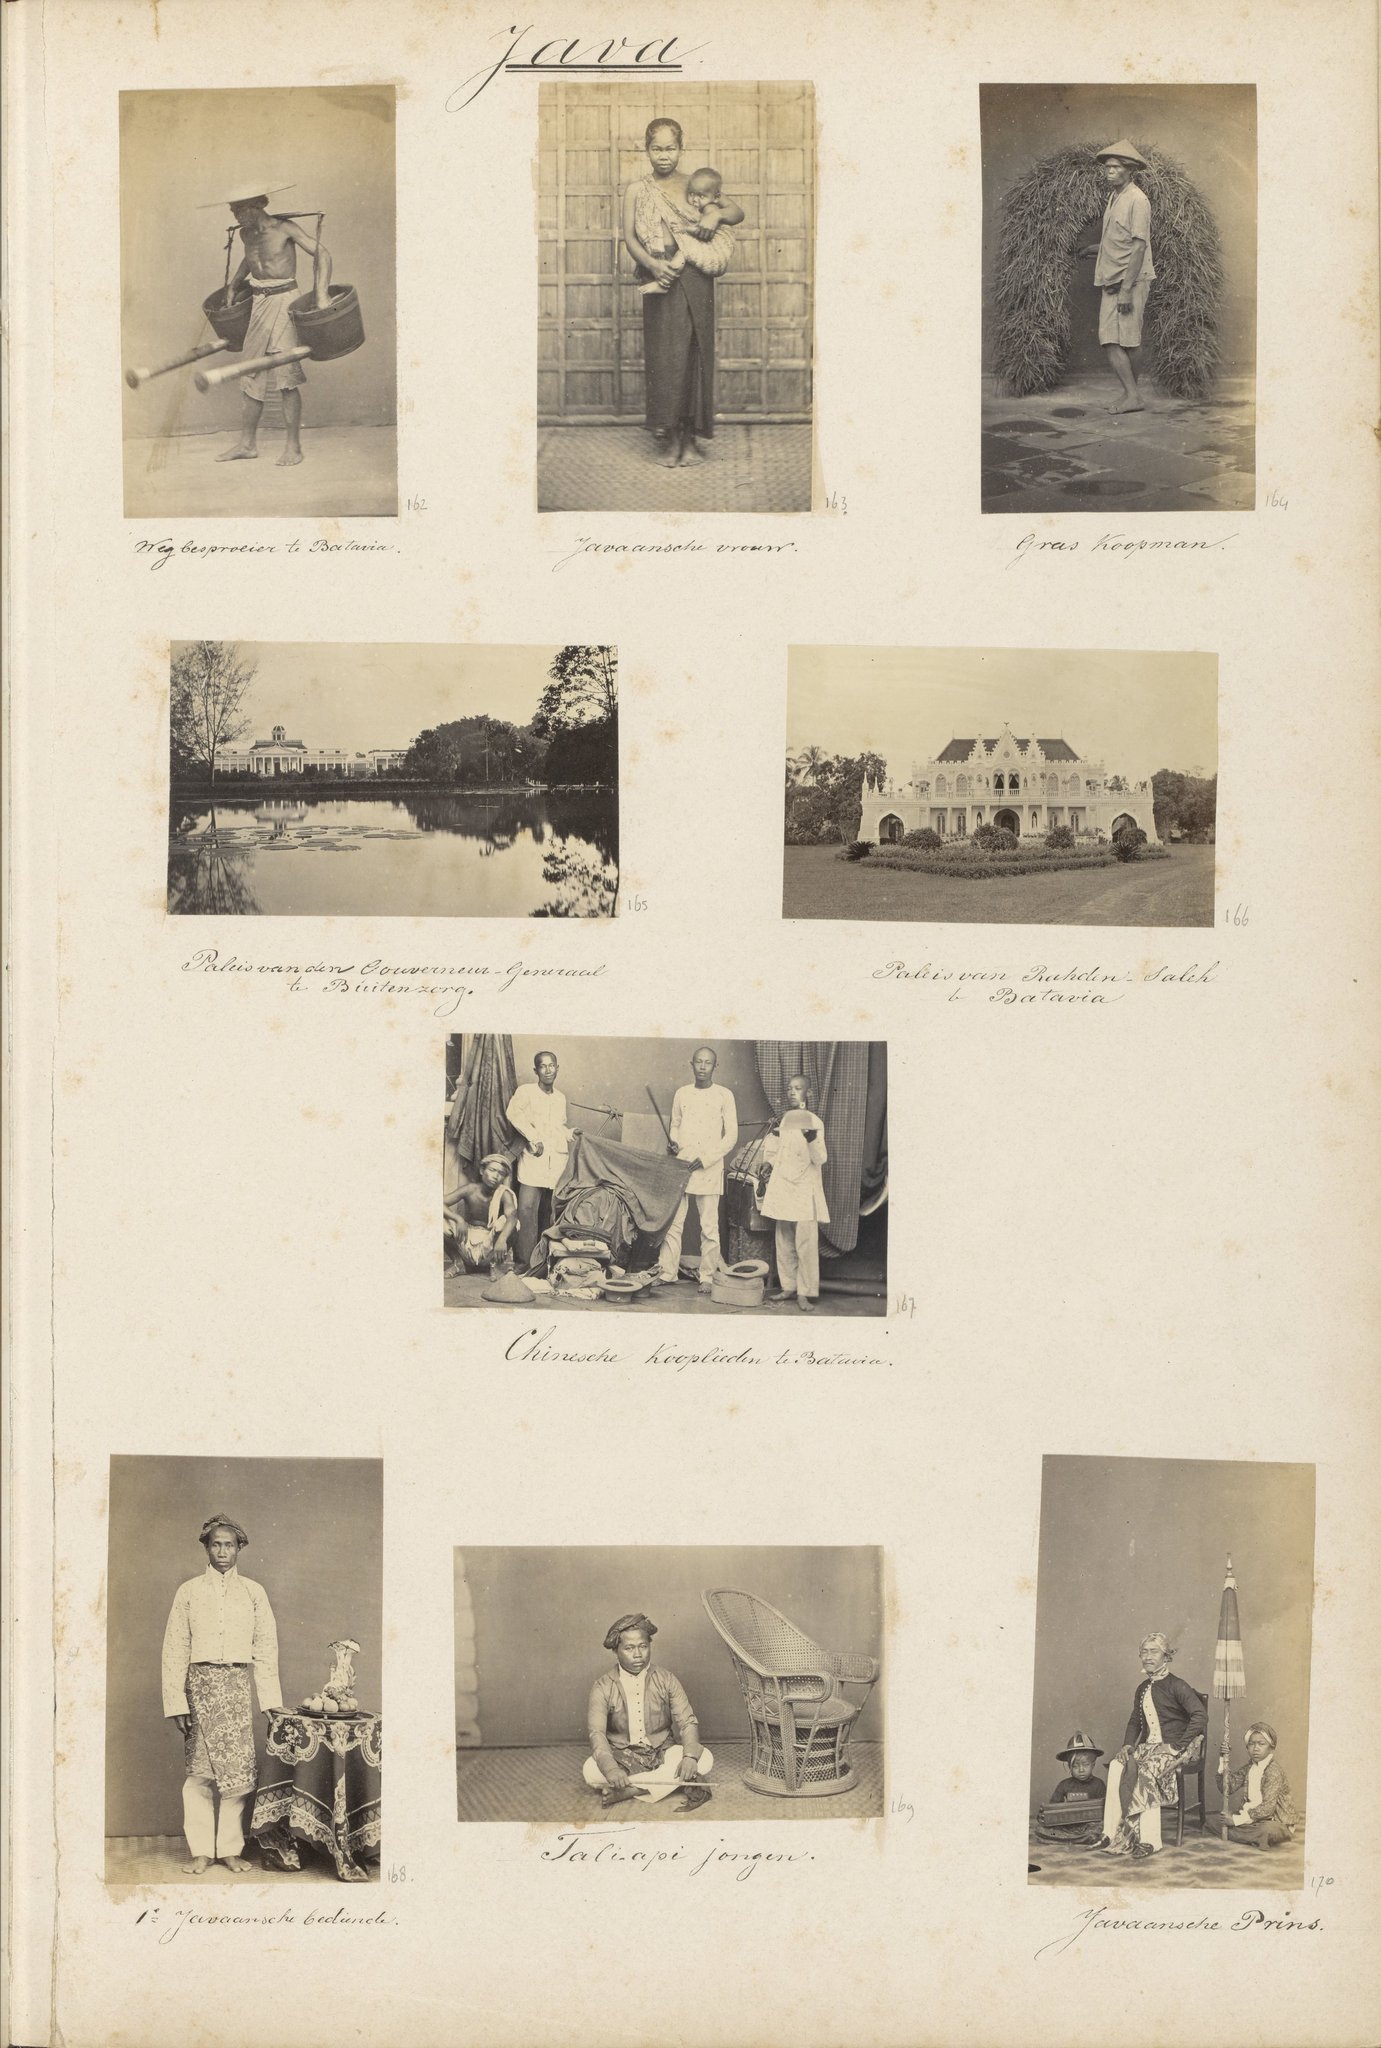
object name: album leaf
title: Gezicht op het paleis van de gouverneur-generaal in Buitenzorg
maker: Anonymous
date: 1870-1880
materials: paper, photographic support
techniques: albumen print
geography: buitenzorg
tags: palace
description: Onderdeel van Fotoalbum van Robert Daniel Crommelin (1841-1907).